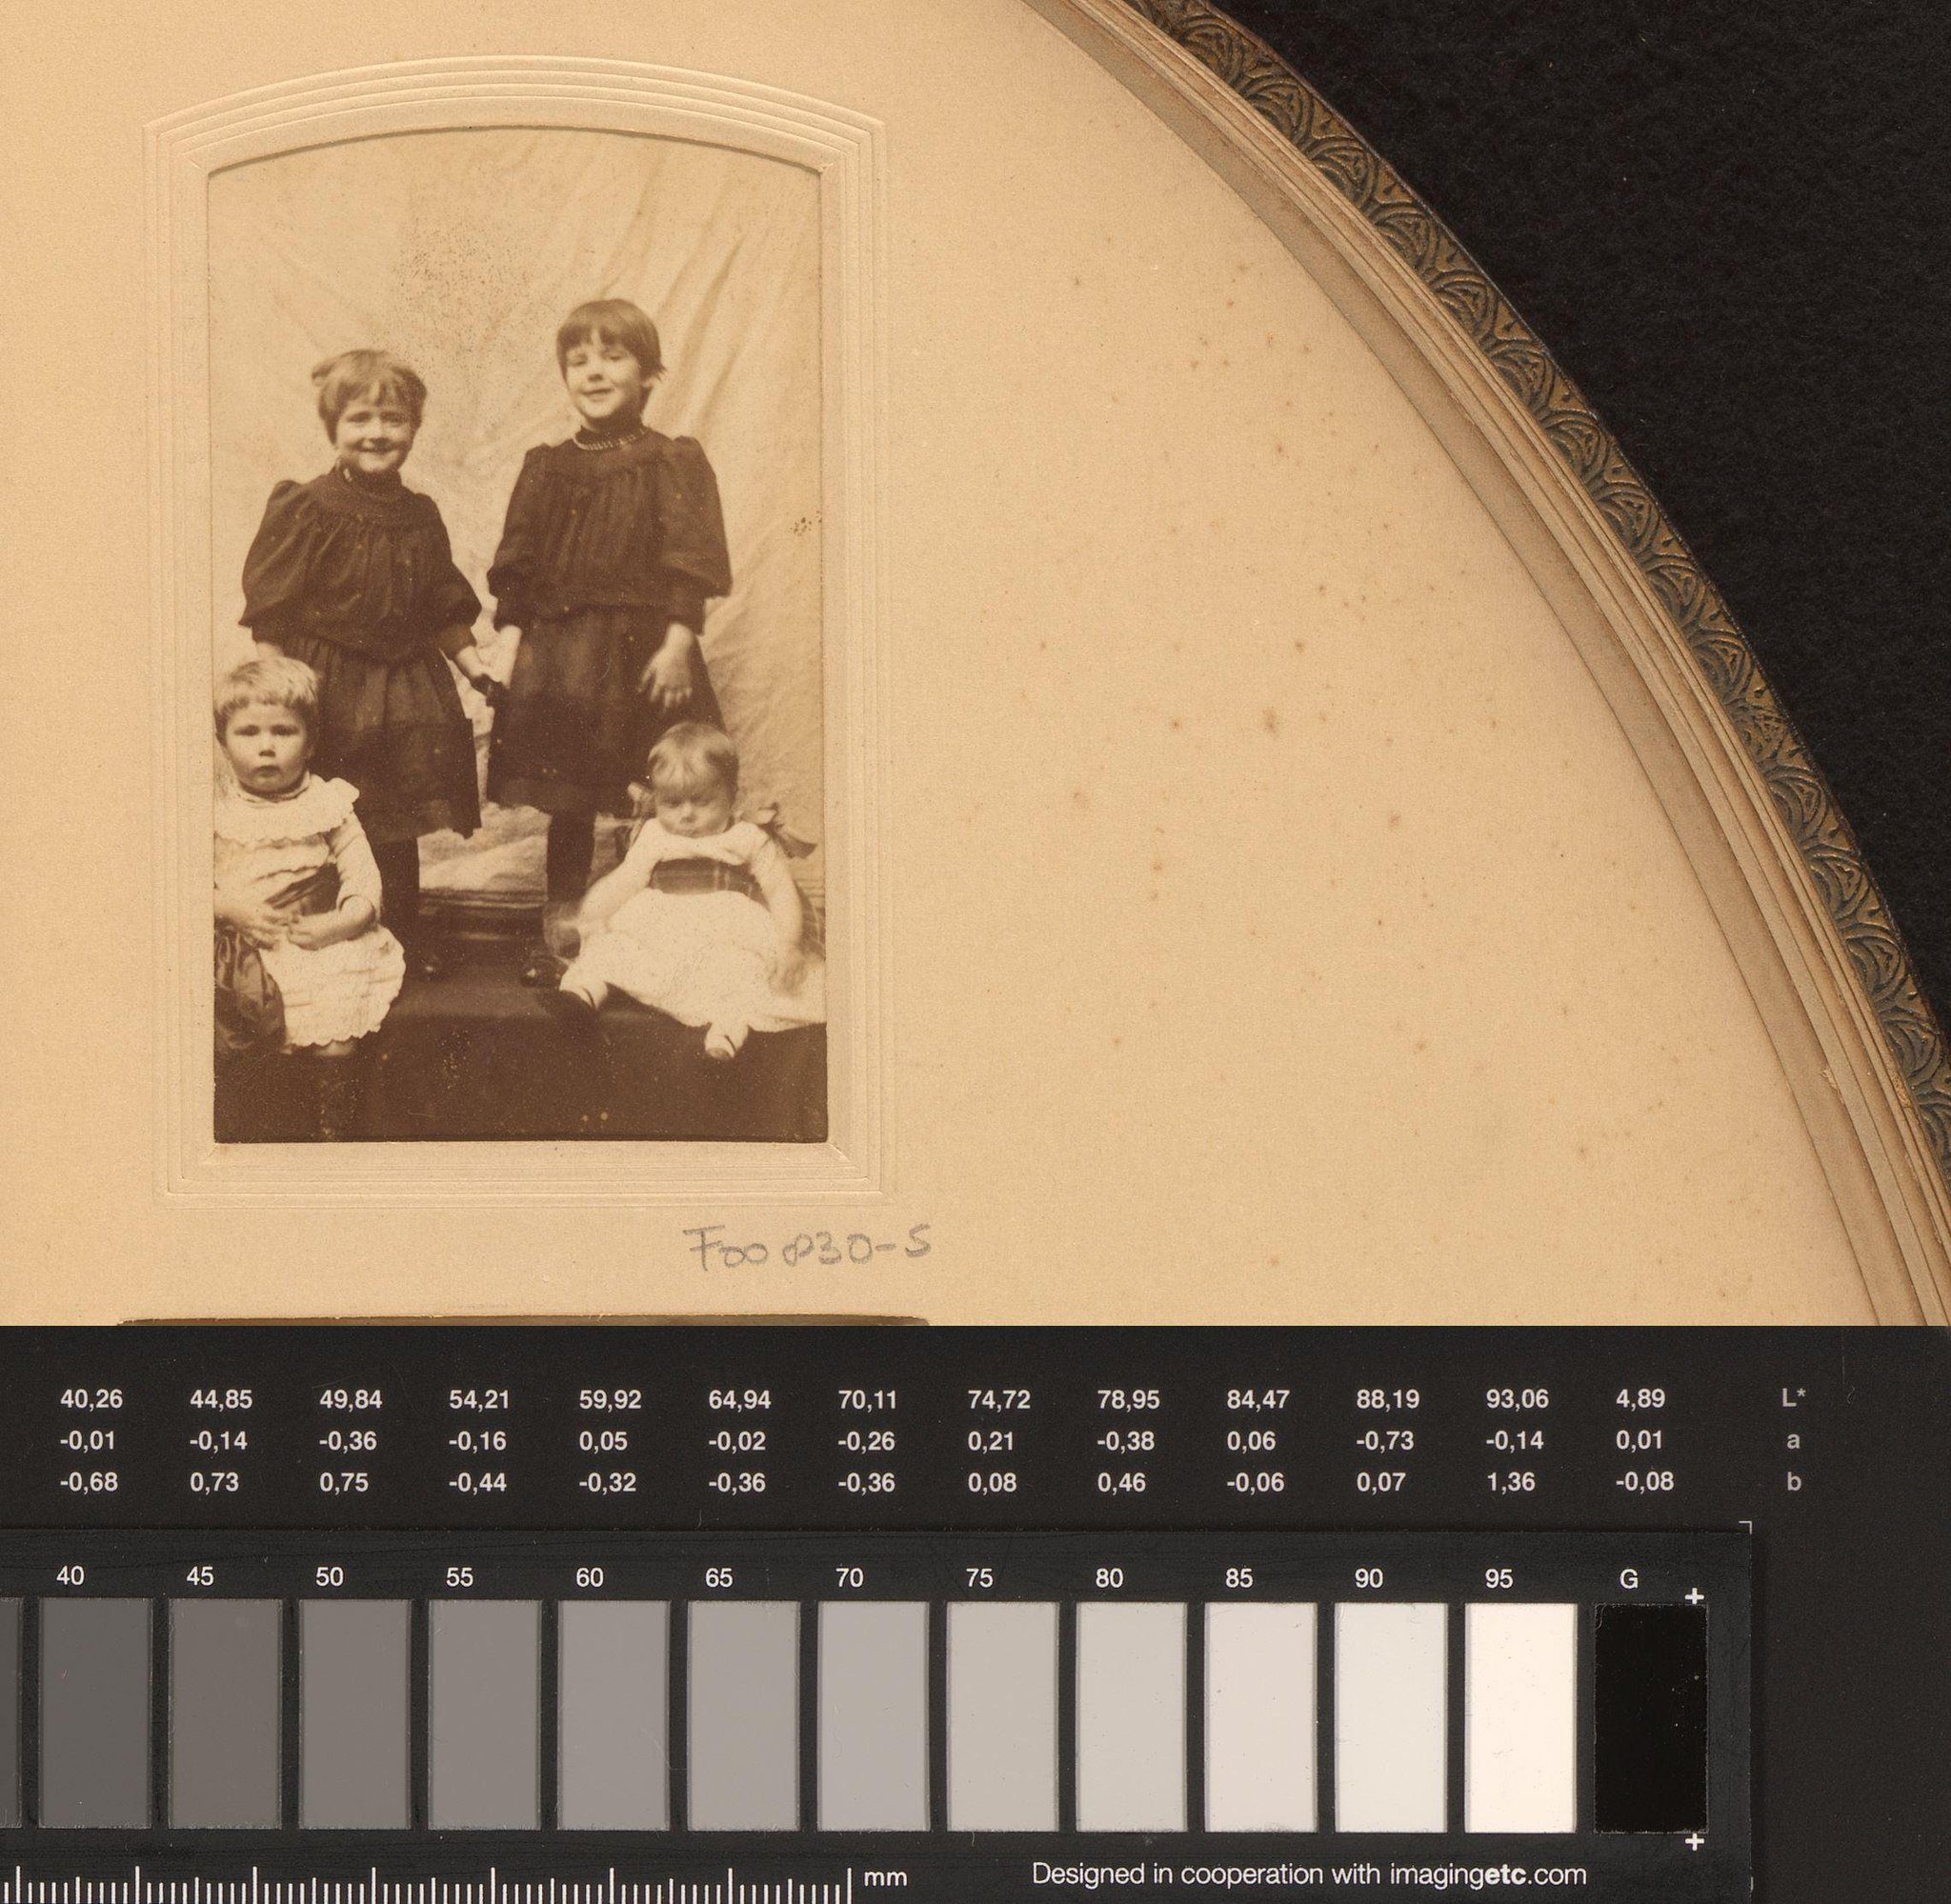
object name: album leaf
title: Groepsportret van vier kinderen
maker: Anonymous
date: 1860-1900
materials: cardboard, photographic support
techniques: albumen print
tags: toddler, historical persons, girl (child between toddler and youth), infant, baby